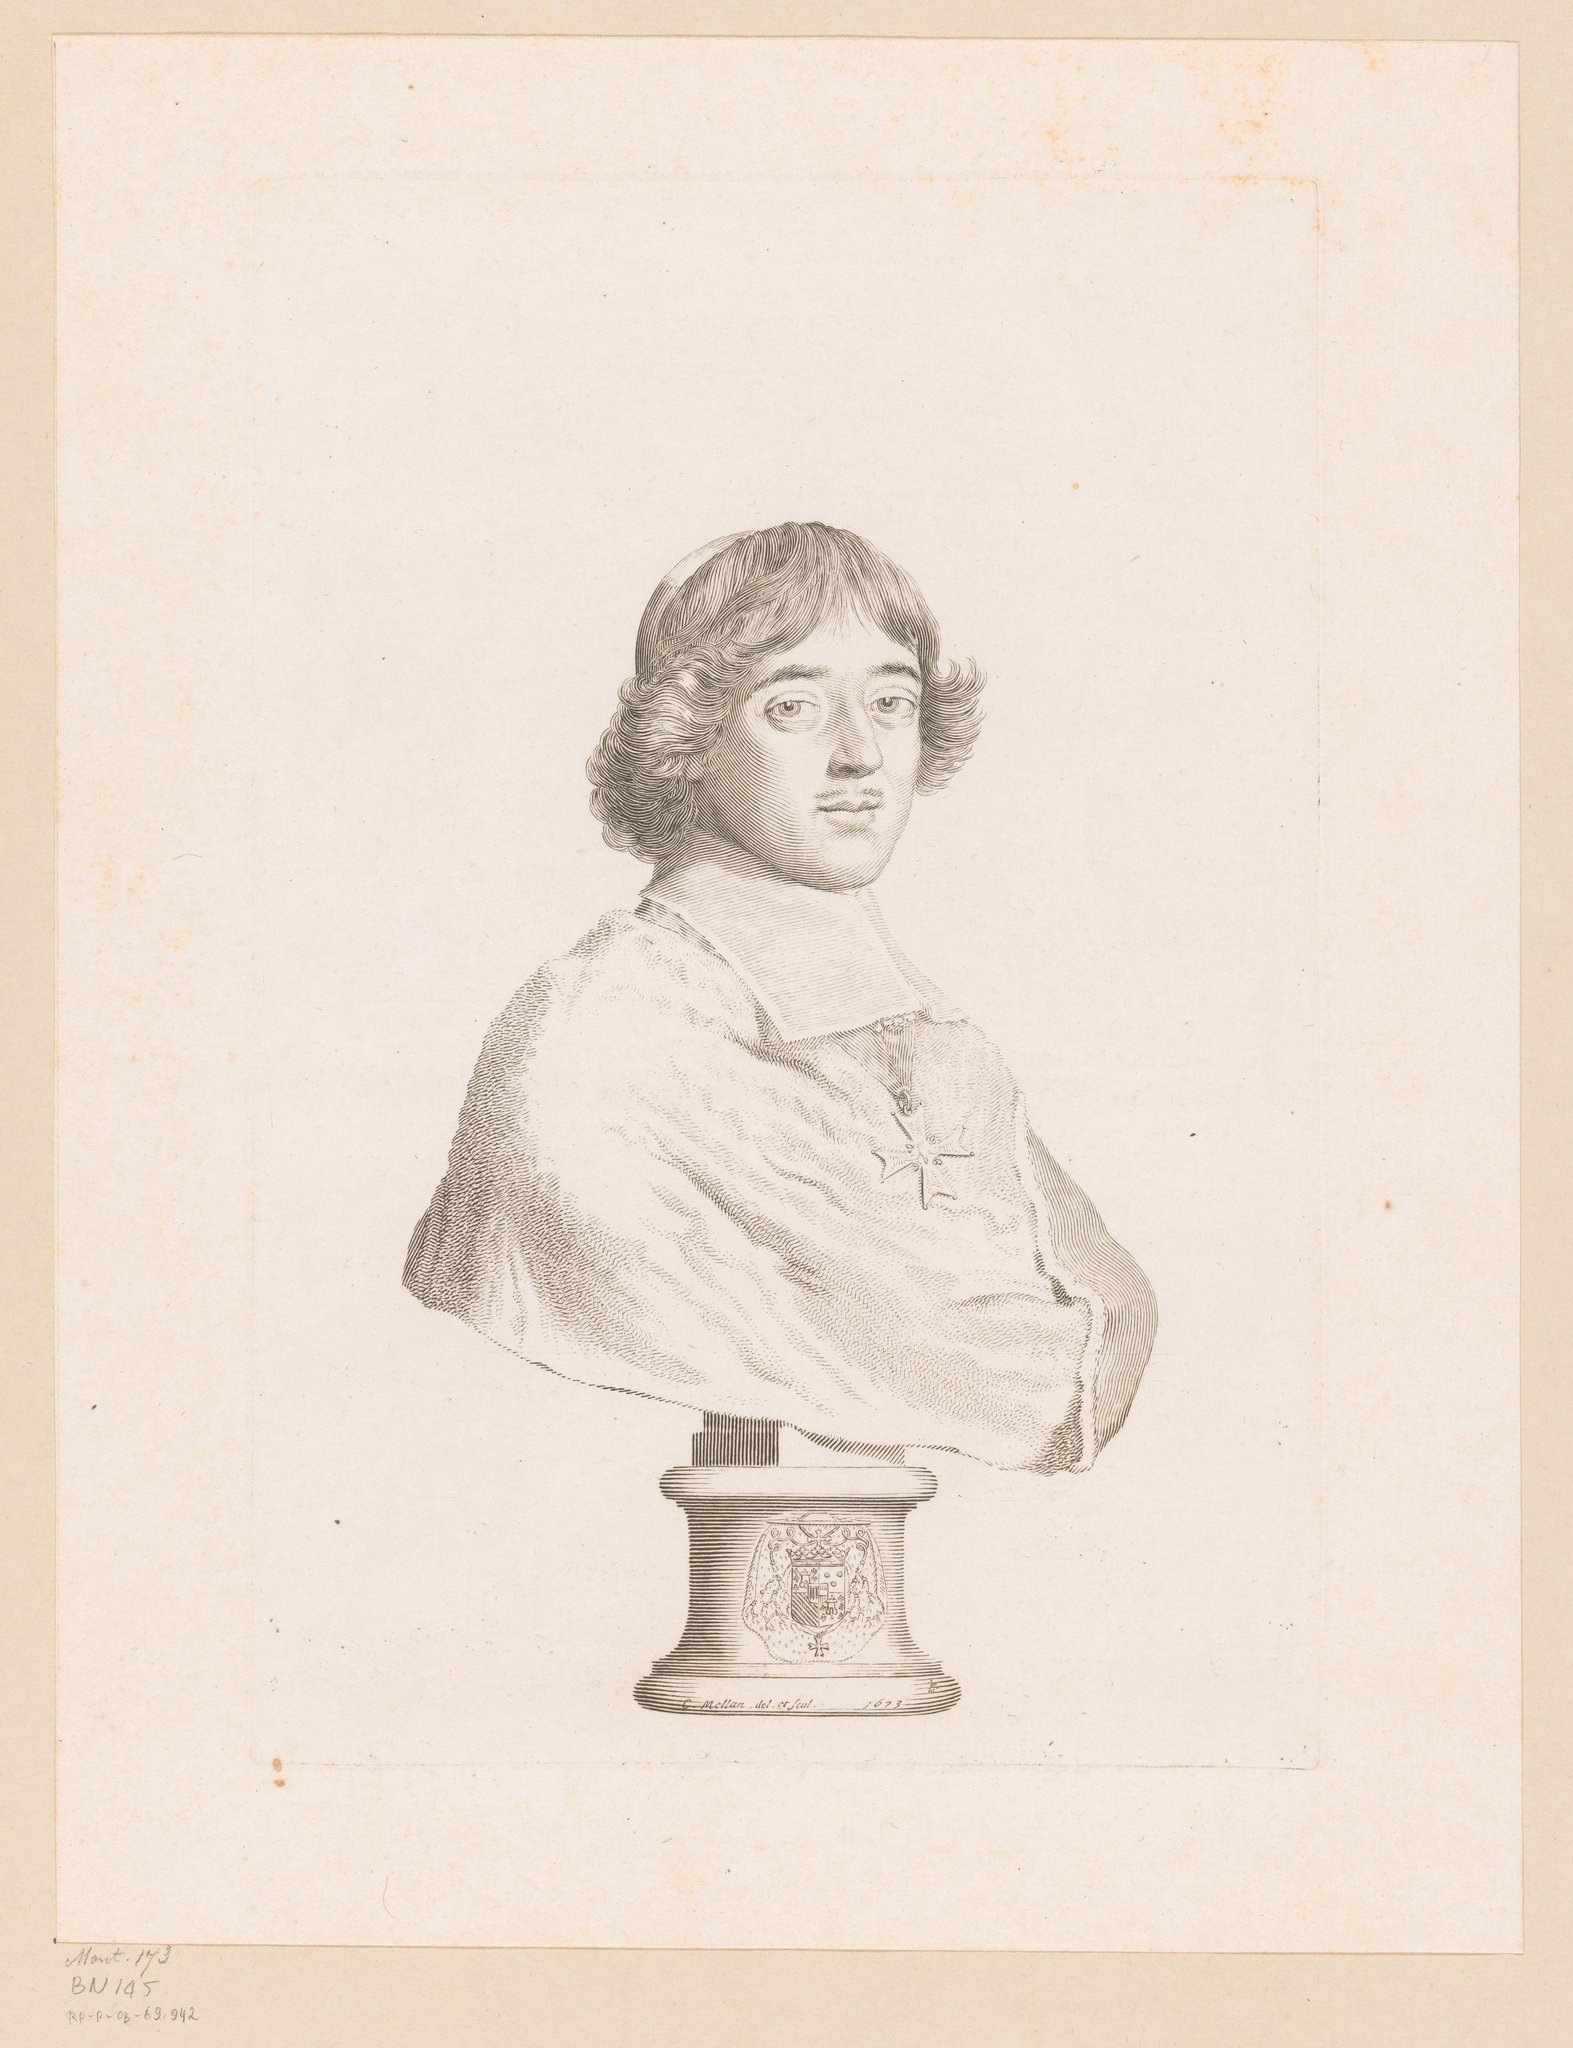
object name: print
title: Portret van Emmanuel-Théodose de La Tour d'Auvergne, hertog van Albret en kardinaal van Bouillon als buste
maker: claude mellan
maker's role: draughtsman, print maker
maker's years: 1598-1688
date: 1673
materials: paper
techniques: engraving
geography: france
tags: emanuel theodius de la tour d'auvergne hertog van bouillon, historical persons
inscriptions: collector's mark: Lugt 240